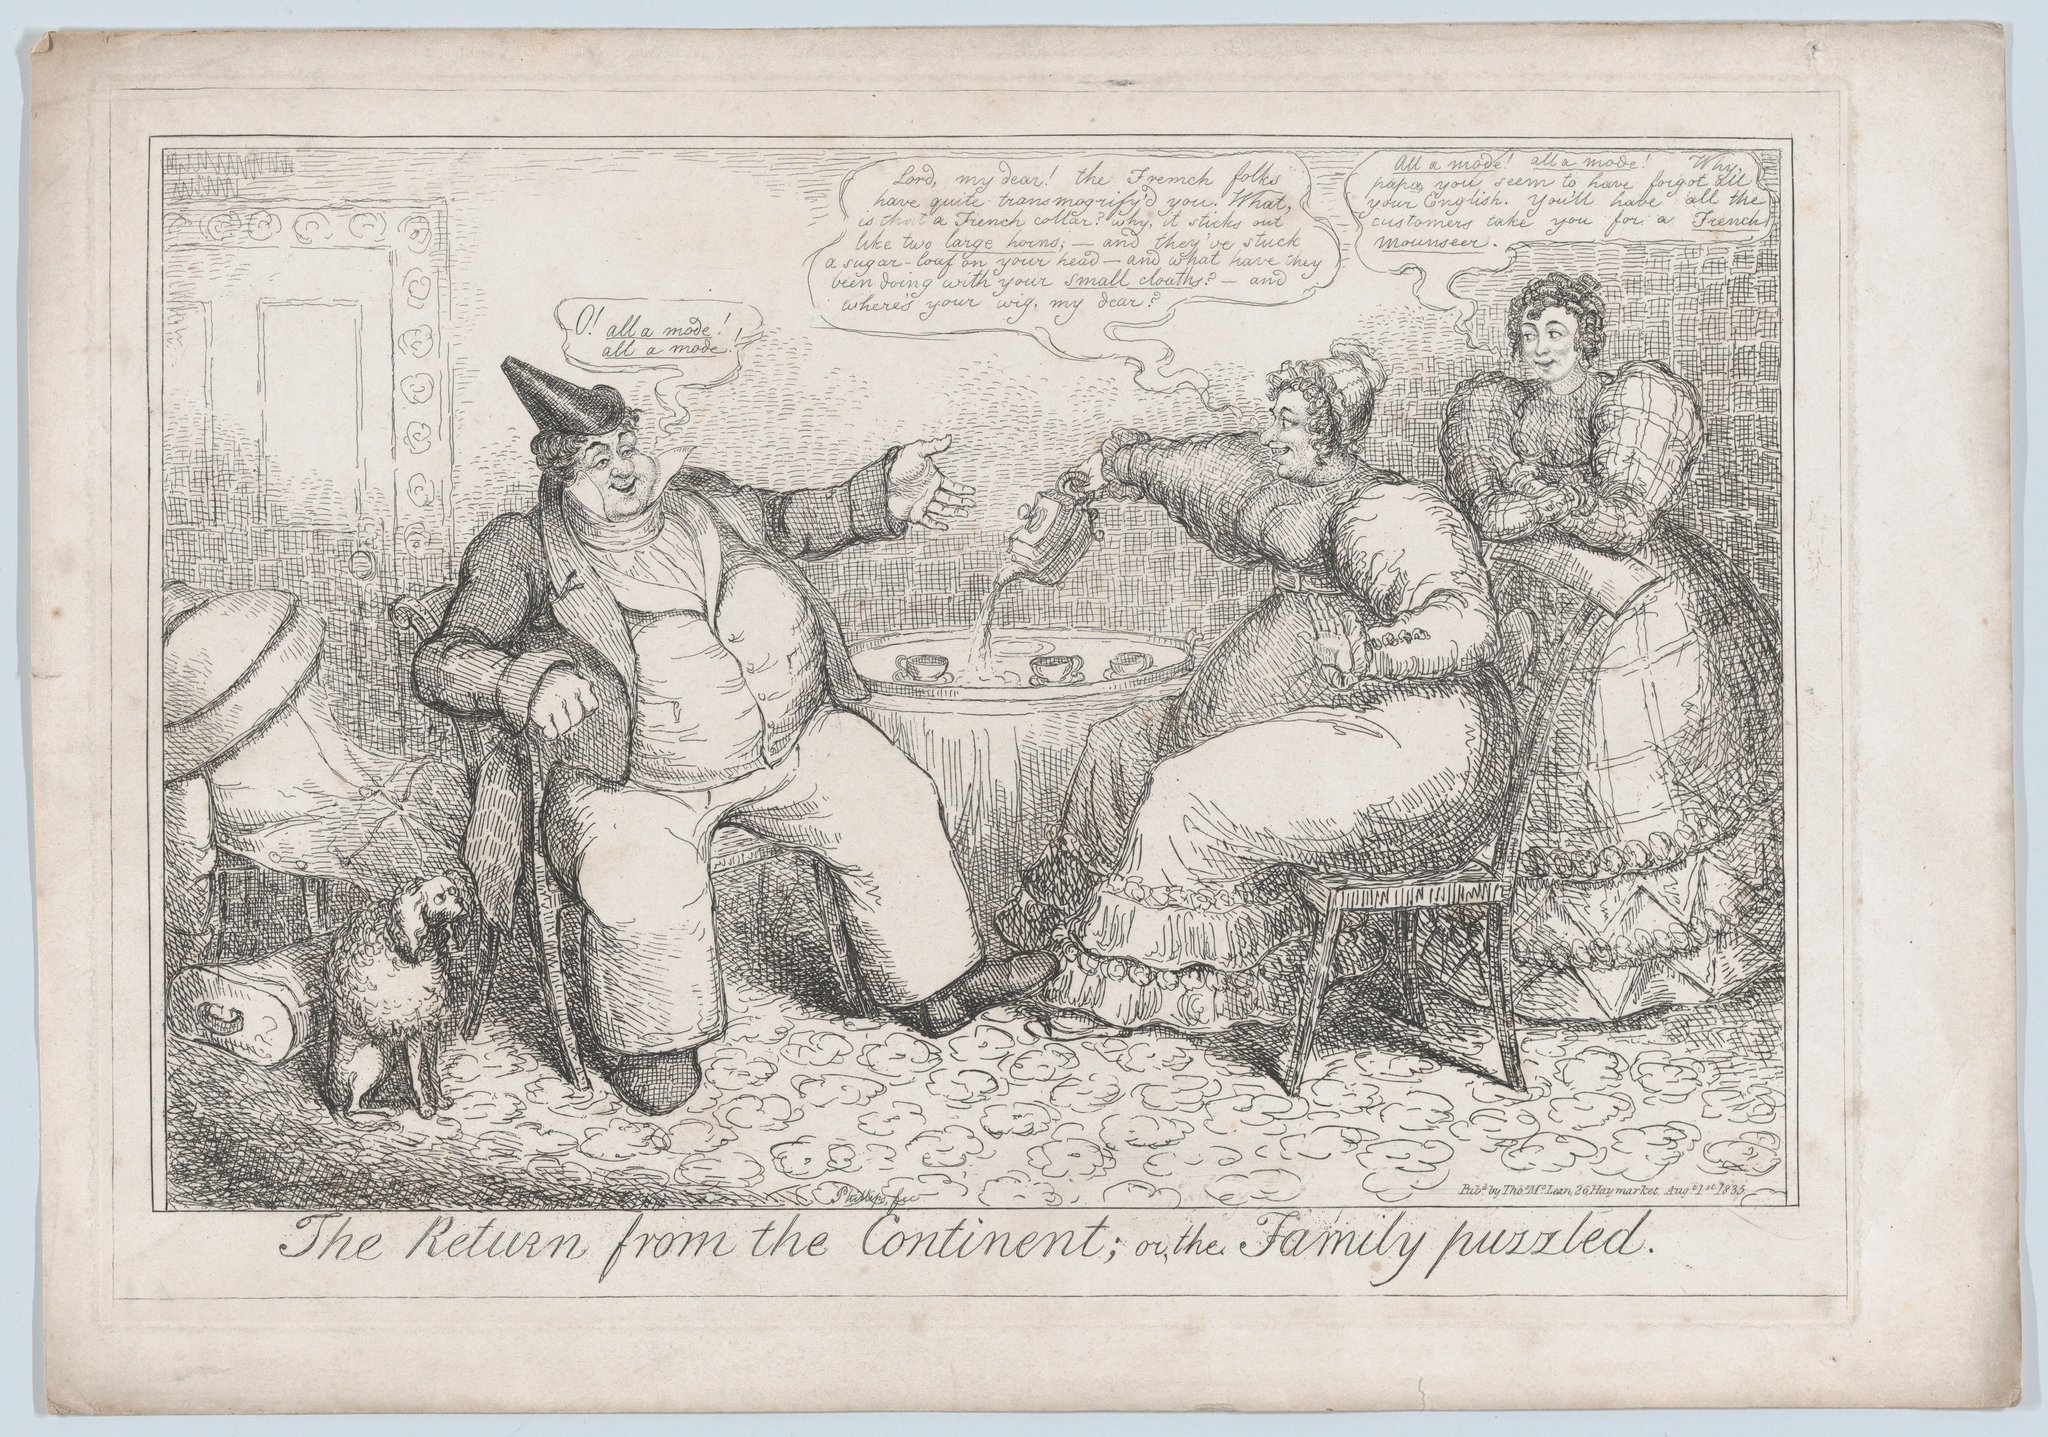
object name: print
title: The Return from the Continent, or the Family Puzzled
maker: john phillips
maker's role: artist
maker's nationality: british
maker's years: 1825-1831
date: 1835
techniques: etching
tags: satire,men,women